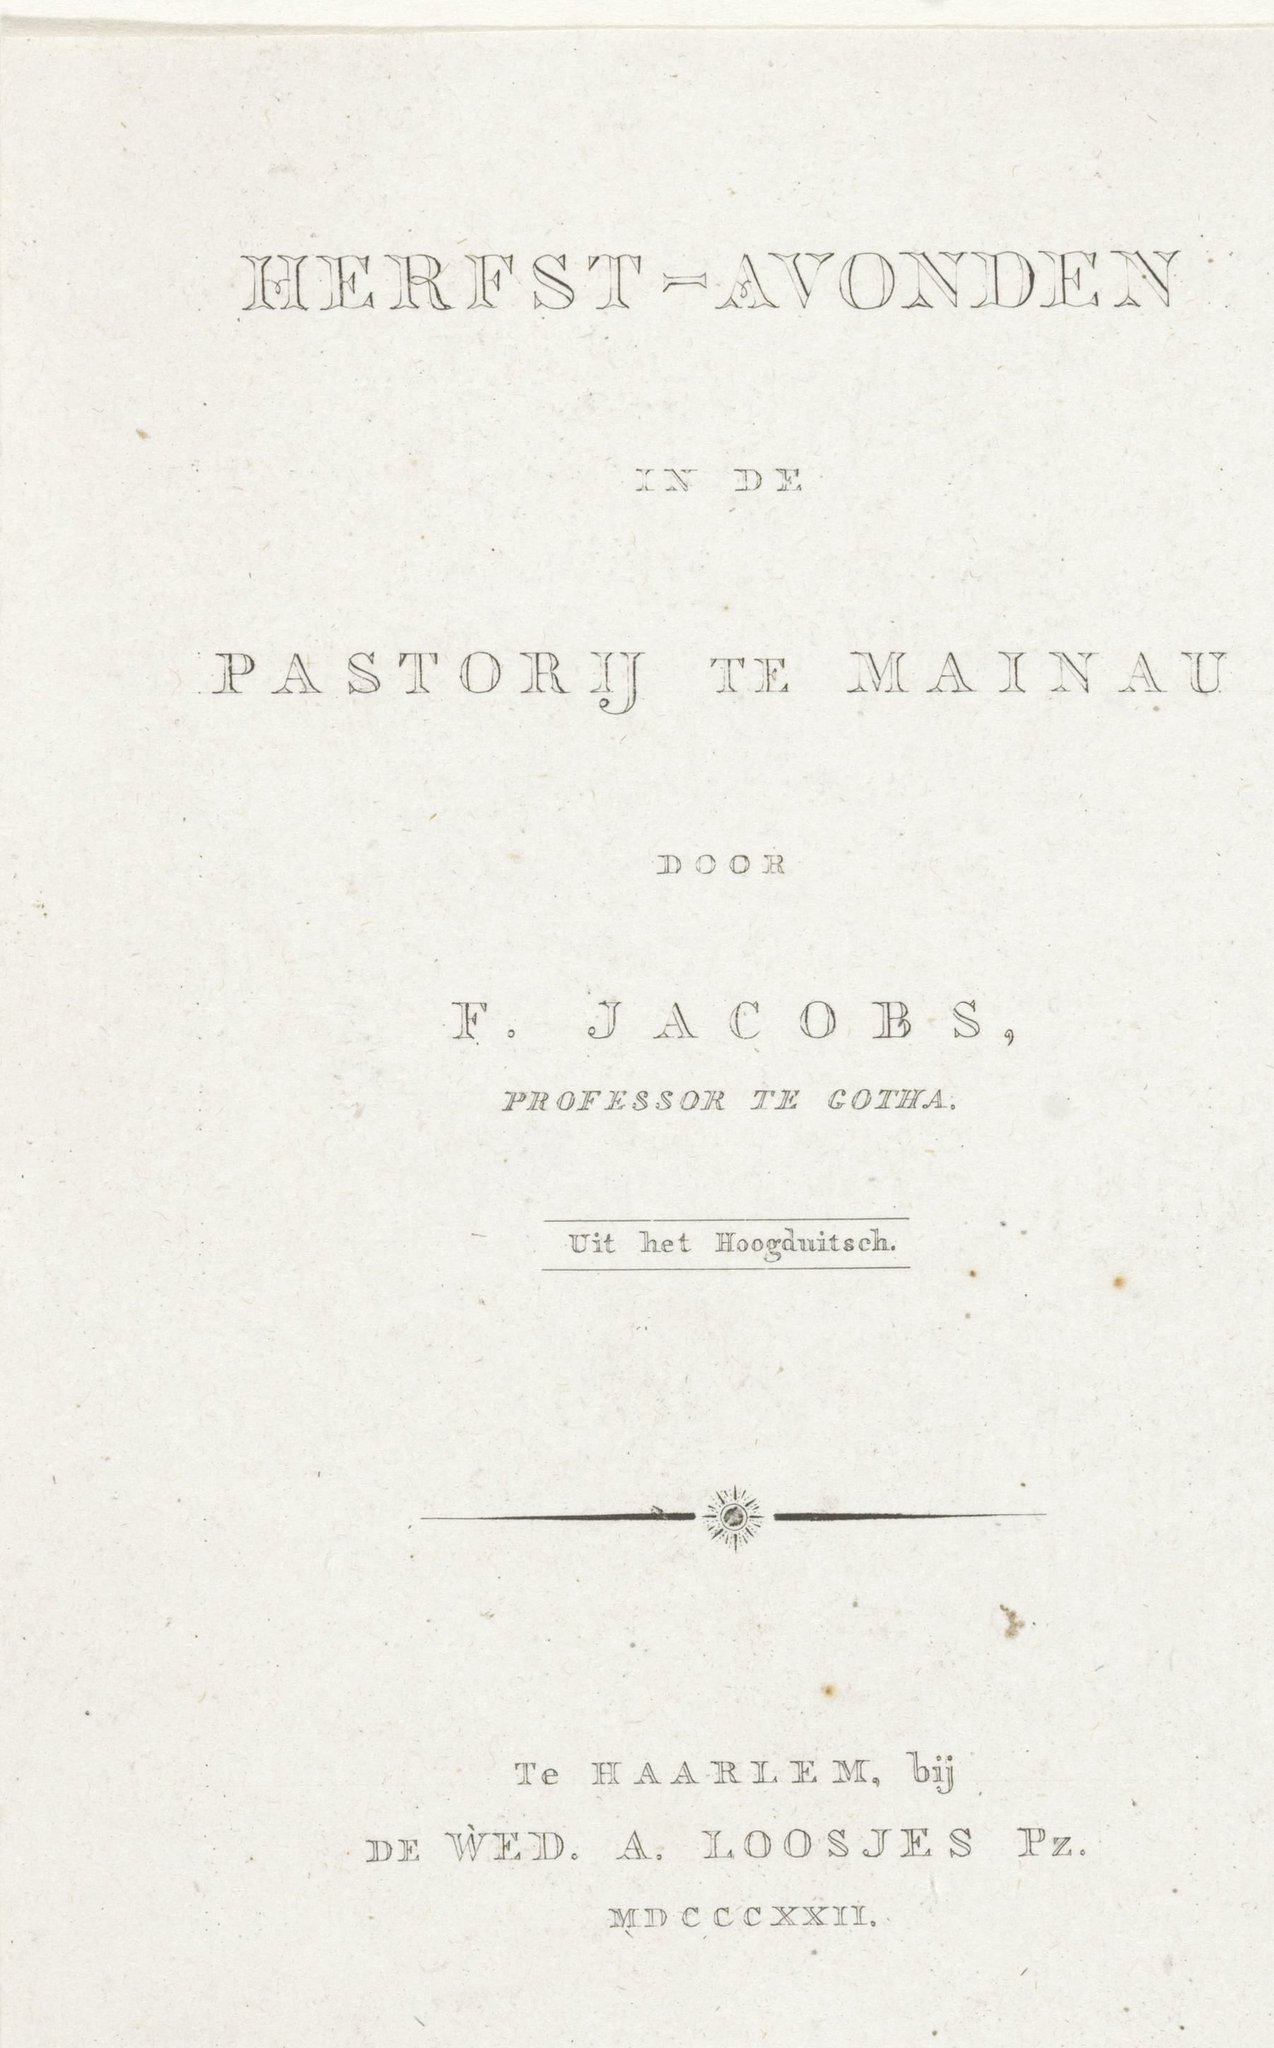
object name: titelblad, titelpagina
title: Titelpagina voor: F. Jacobs, Herfst-avonden in de pastorij te Mainau, 1822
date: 1822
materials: paper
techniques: engraving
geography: haarlem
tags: title-page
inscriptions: collector's mark: Lugt 2228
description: Titelpagina voor: Jacobs, F. Herfst-avonden in de pastorij te Mainau. Haarlem: Loosjes Pz., weduwe Adriaan, 1822.